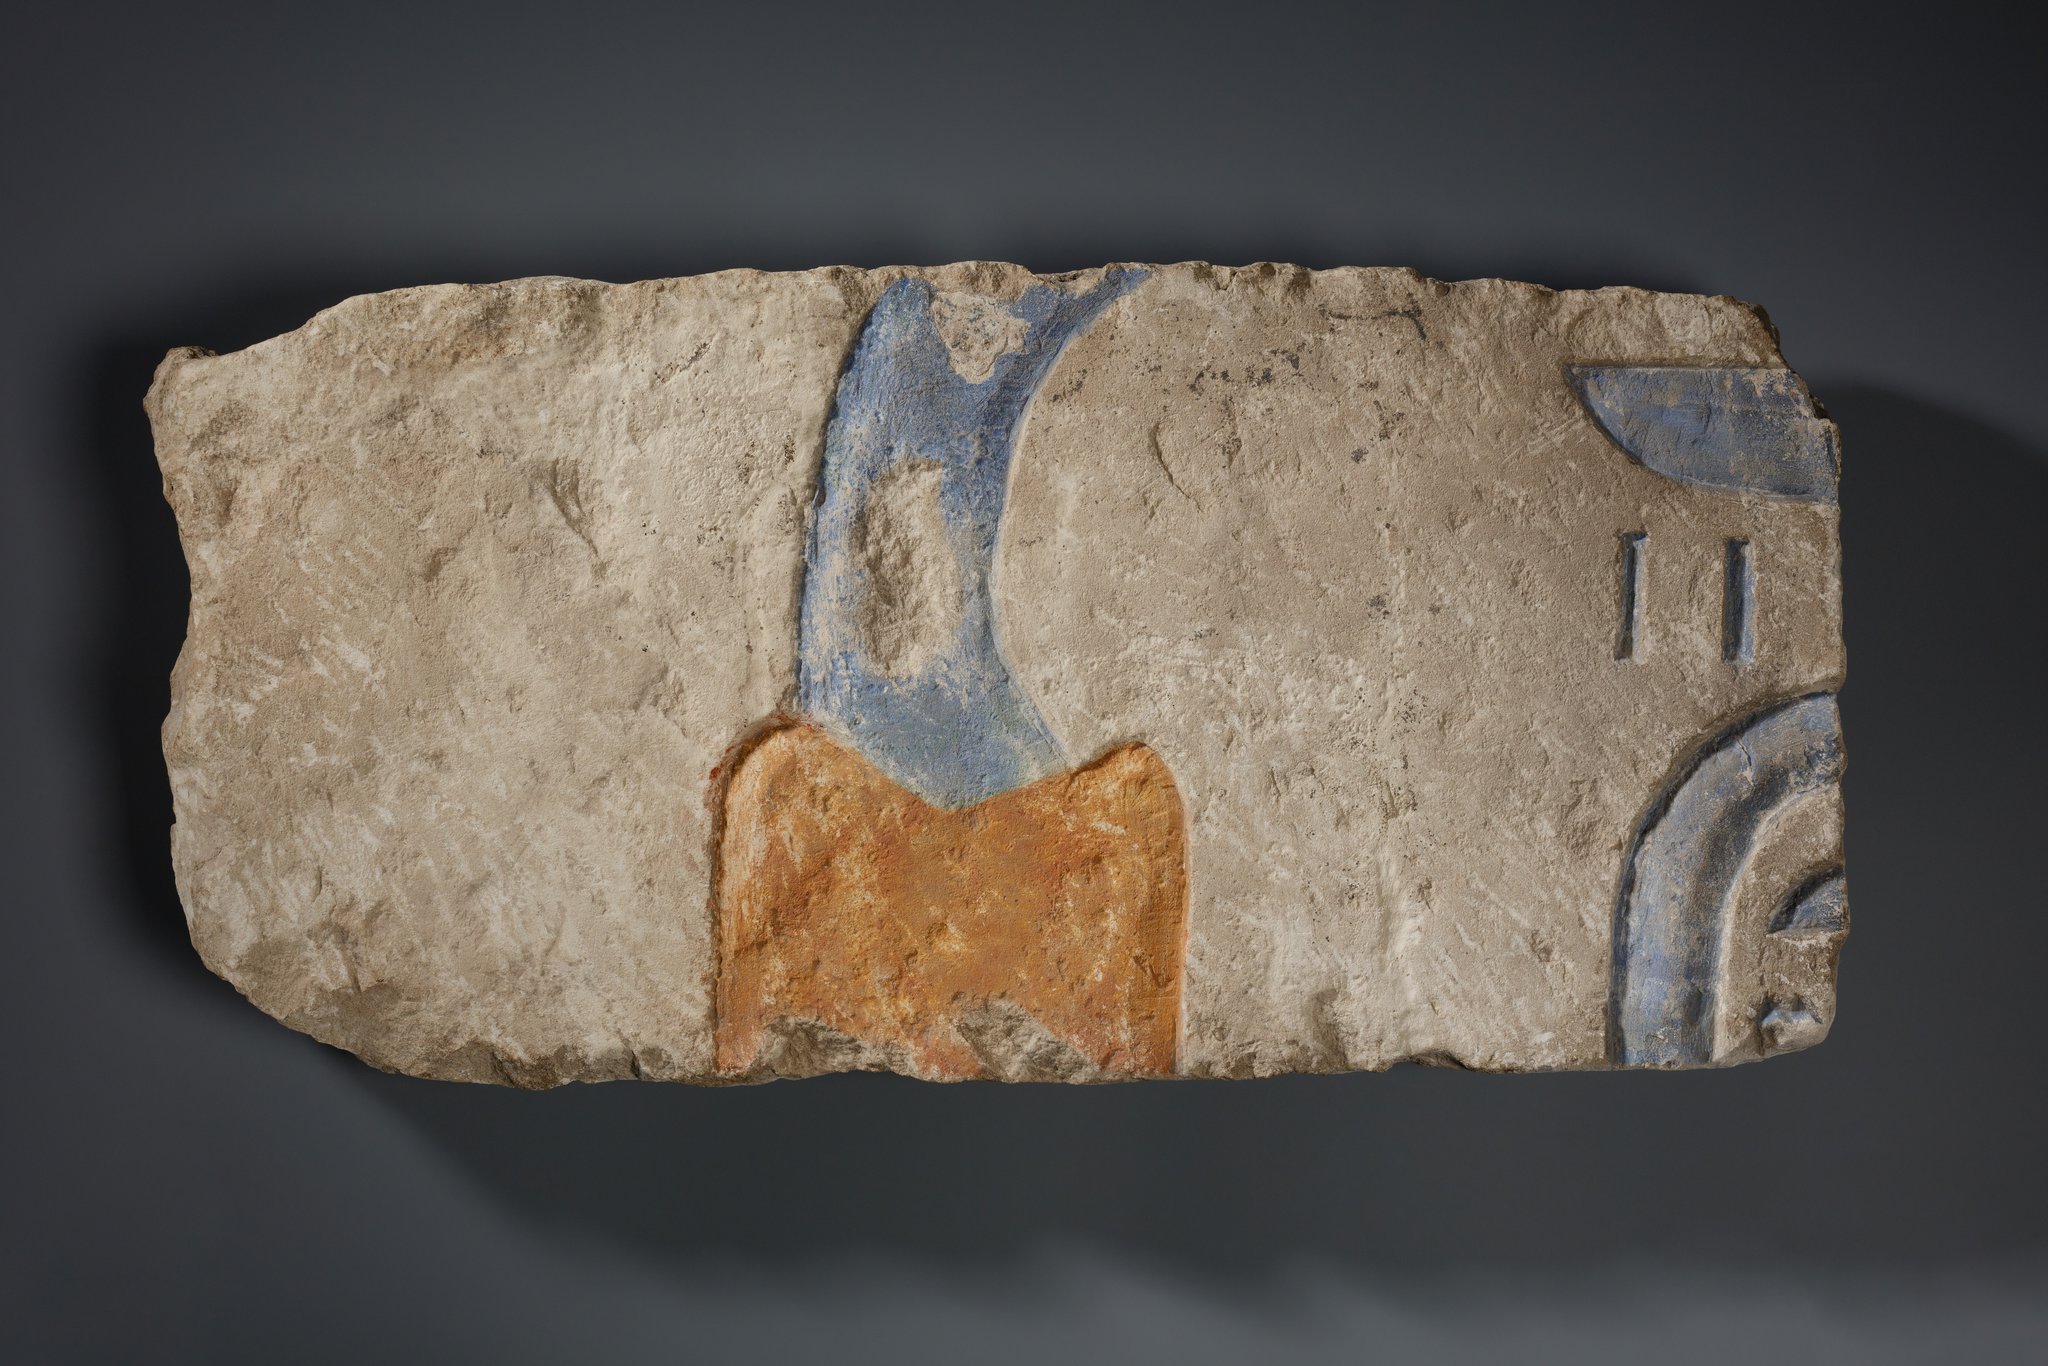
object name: relief, royal title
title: Relief fragment with royal titles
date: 1353-1336 BCE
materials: limestone, paint